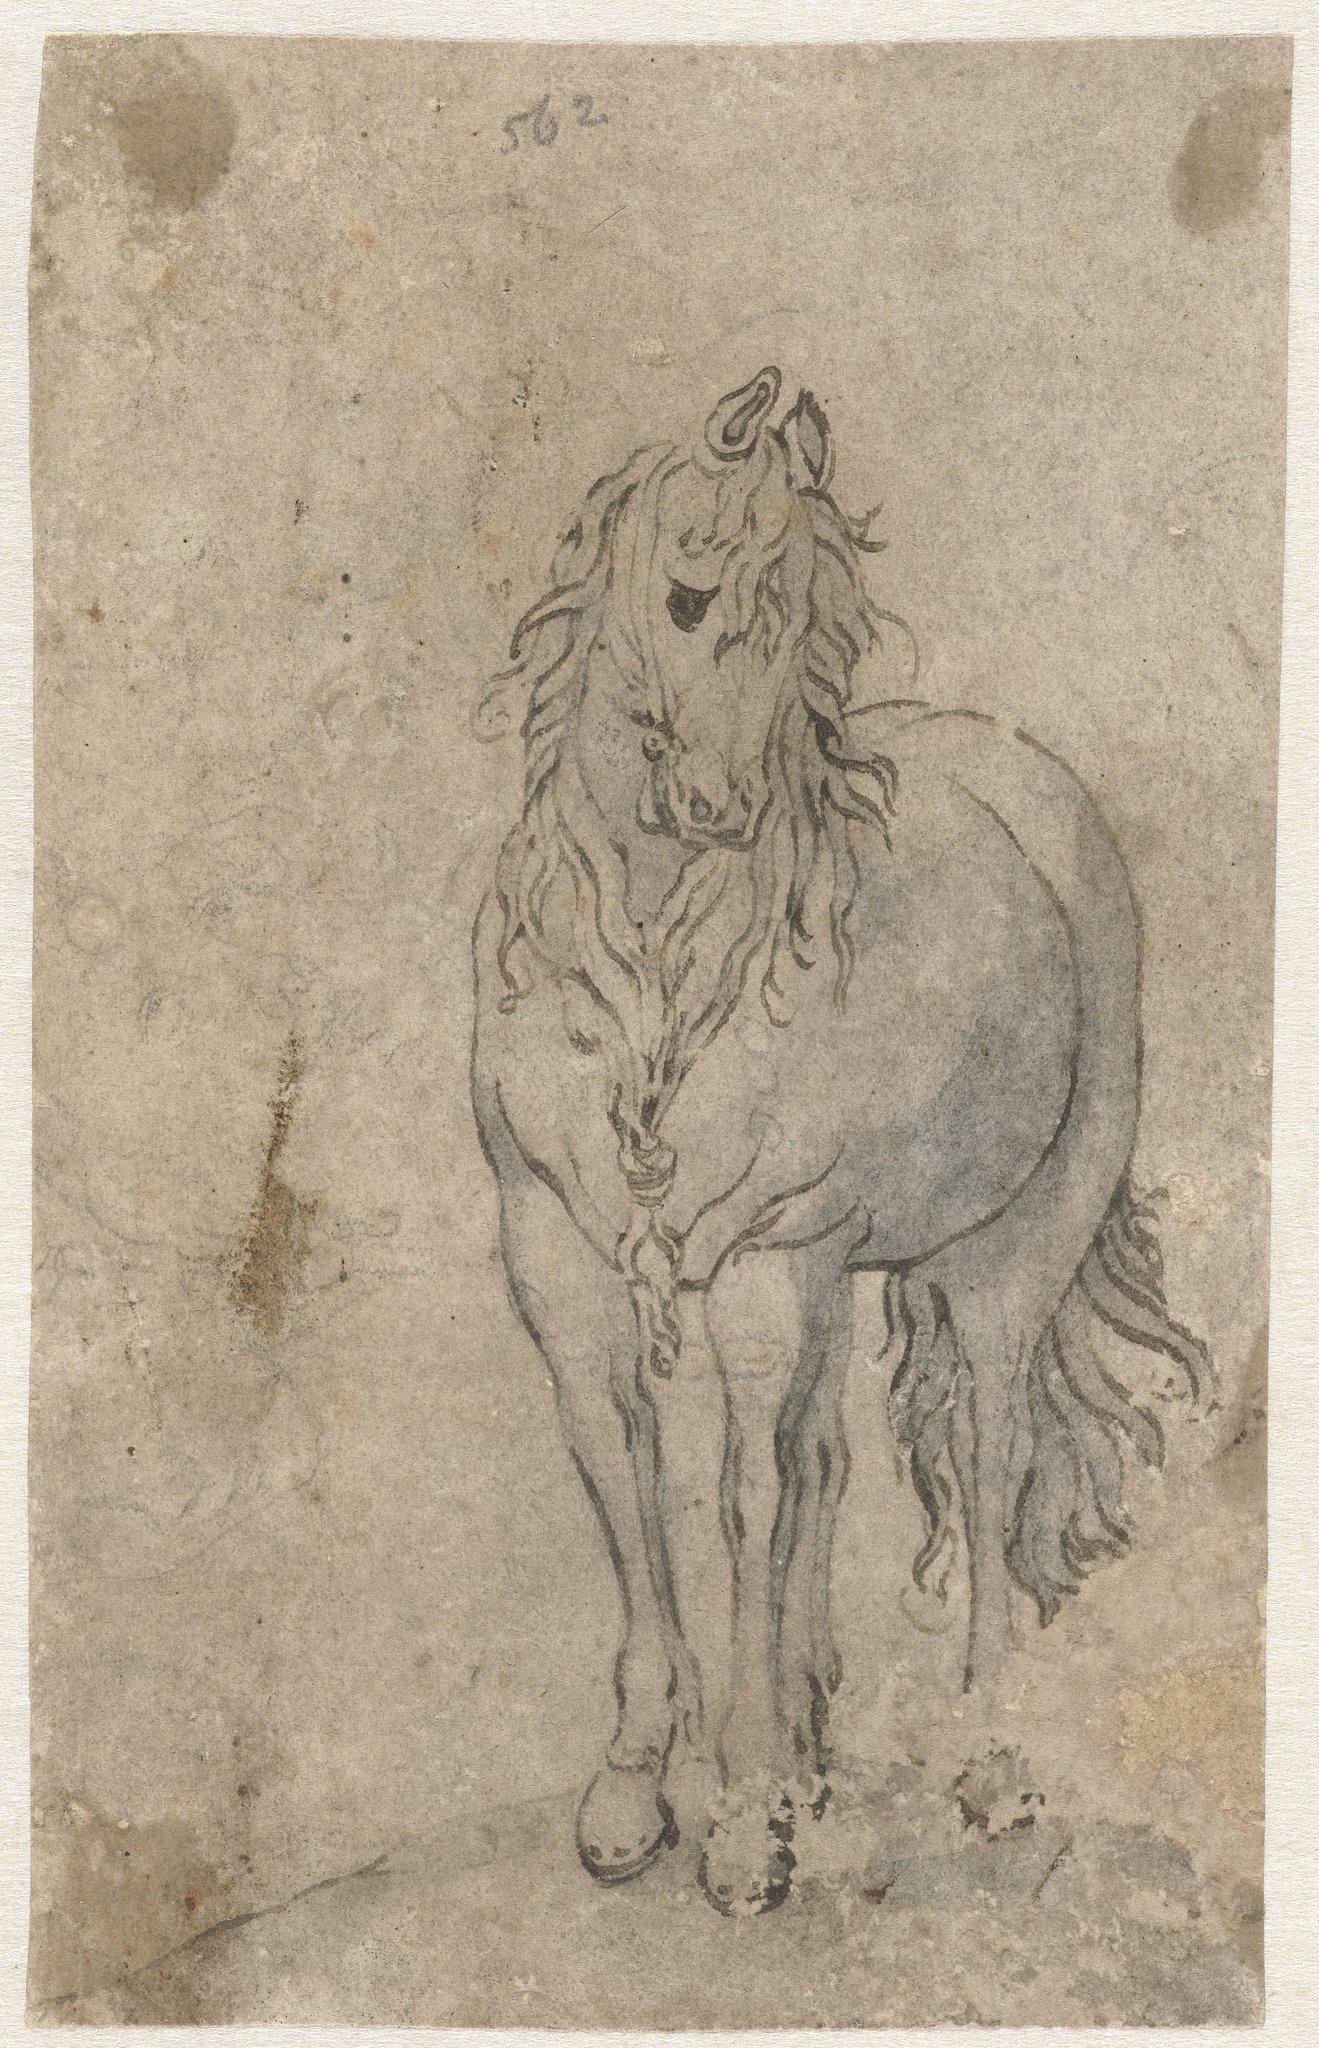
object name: drawing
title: Paard van voren gezien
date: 1610-1650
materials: ink, paper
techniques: brush, pen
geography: netherlands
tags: horse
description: Drawings from the Ter Borch Studio Estate [2 dln.]. Catalogus van de Nederlandse tekeningen in het Rijksprentenkabinet, Amsterdam. Dl. V, 1988; dl. 2, p 773